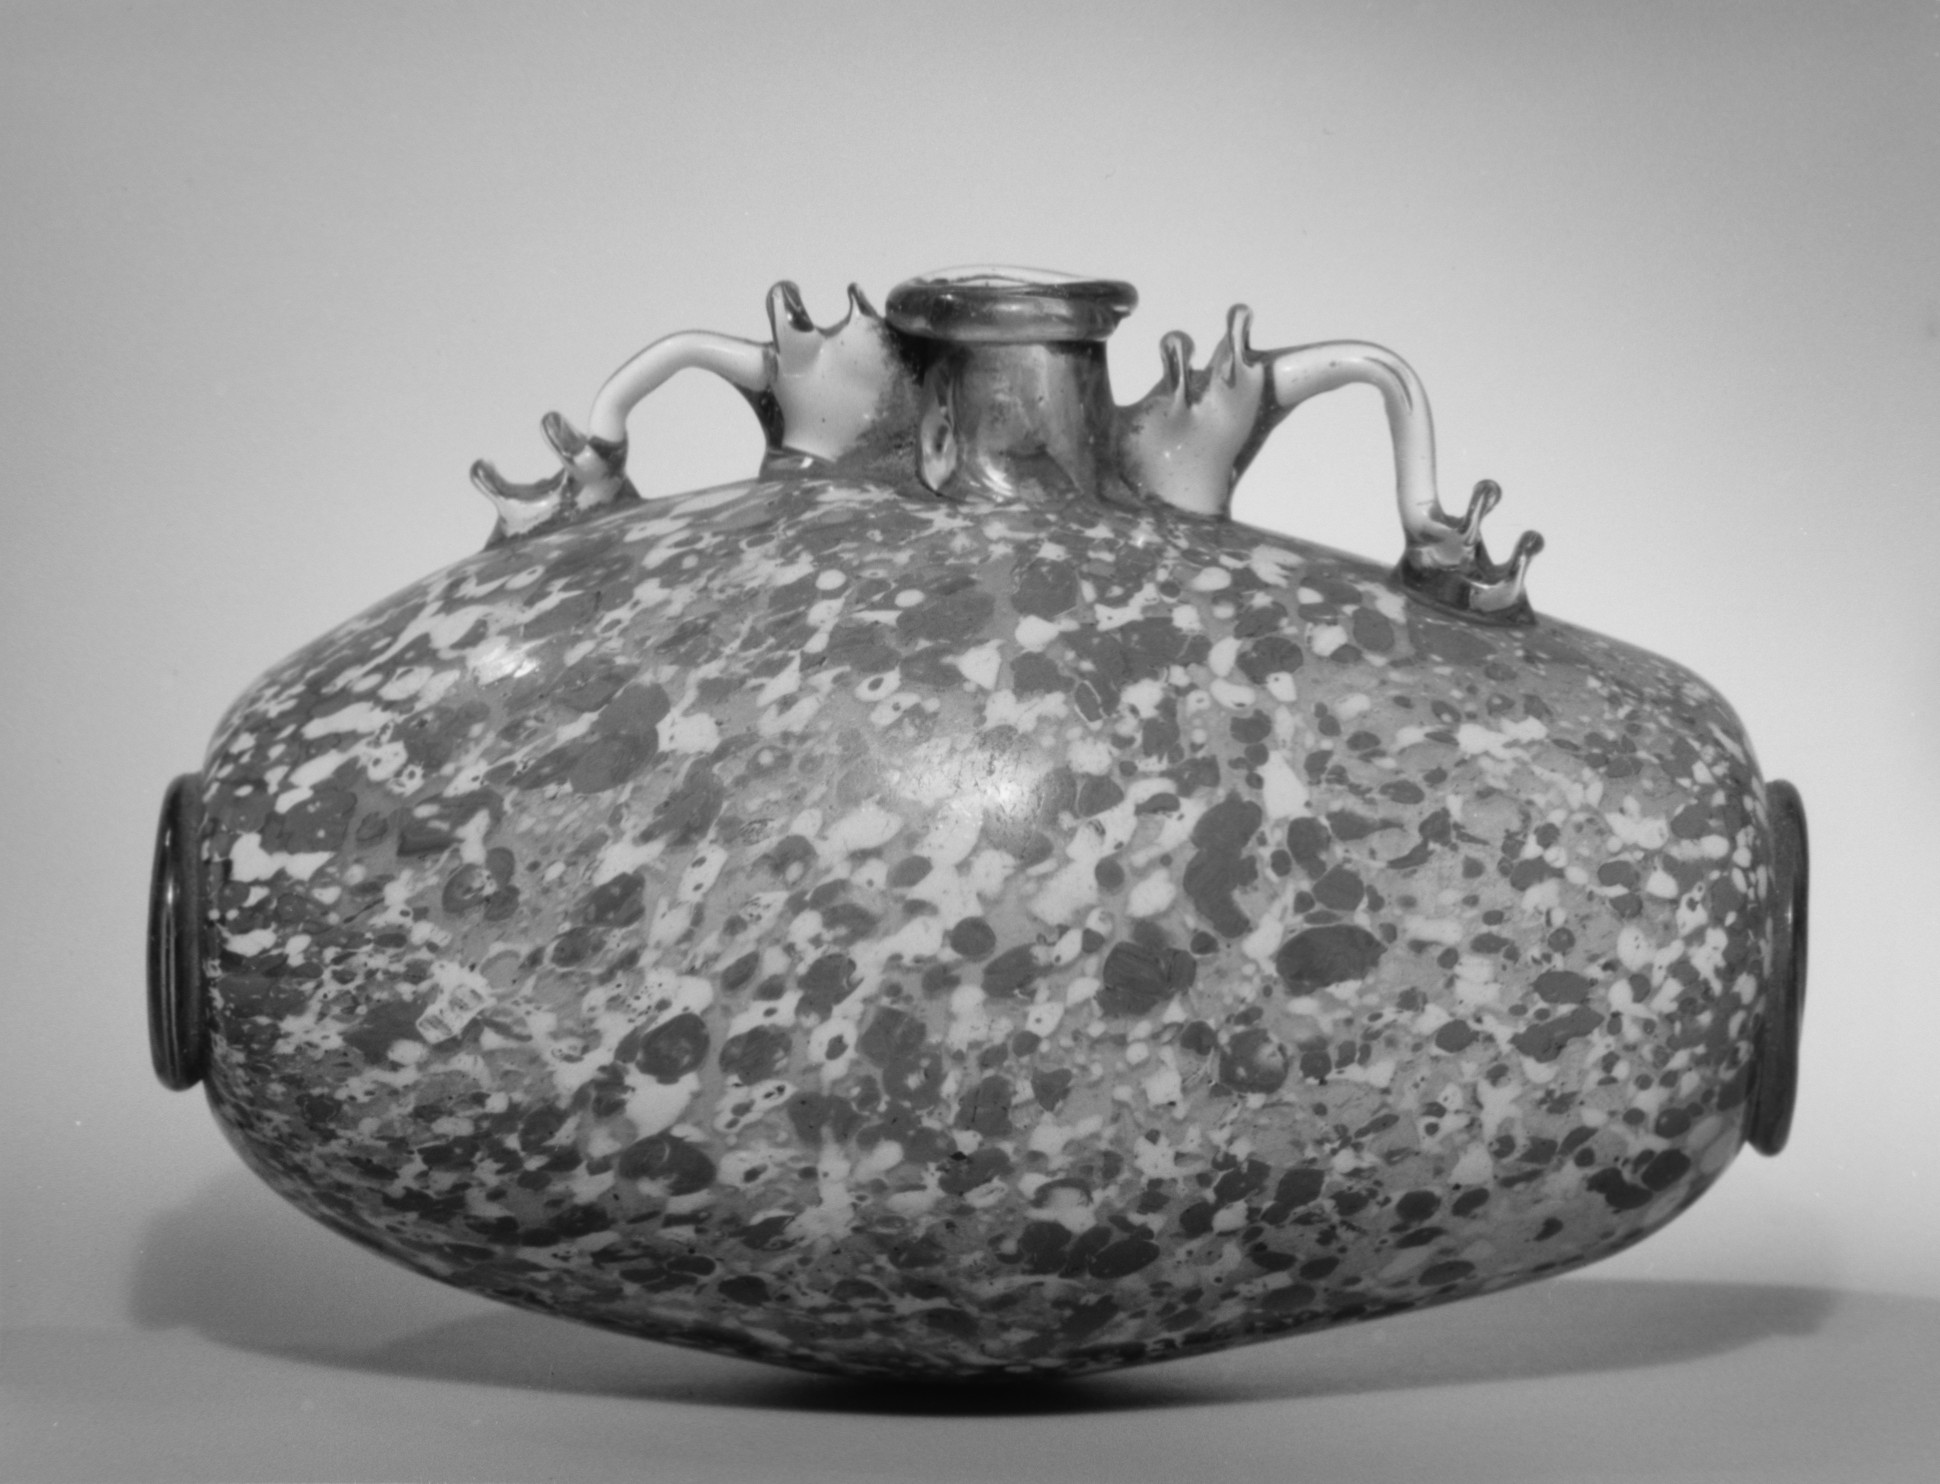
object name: flask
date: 1601-1700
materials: glass